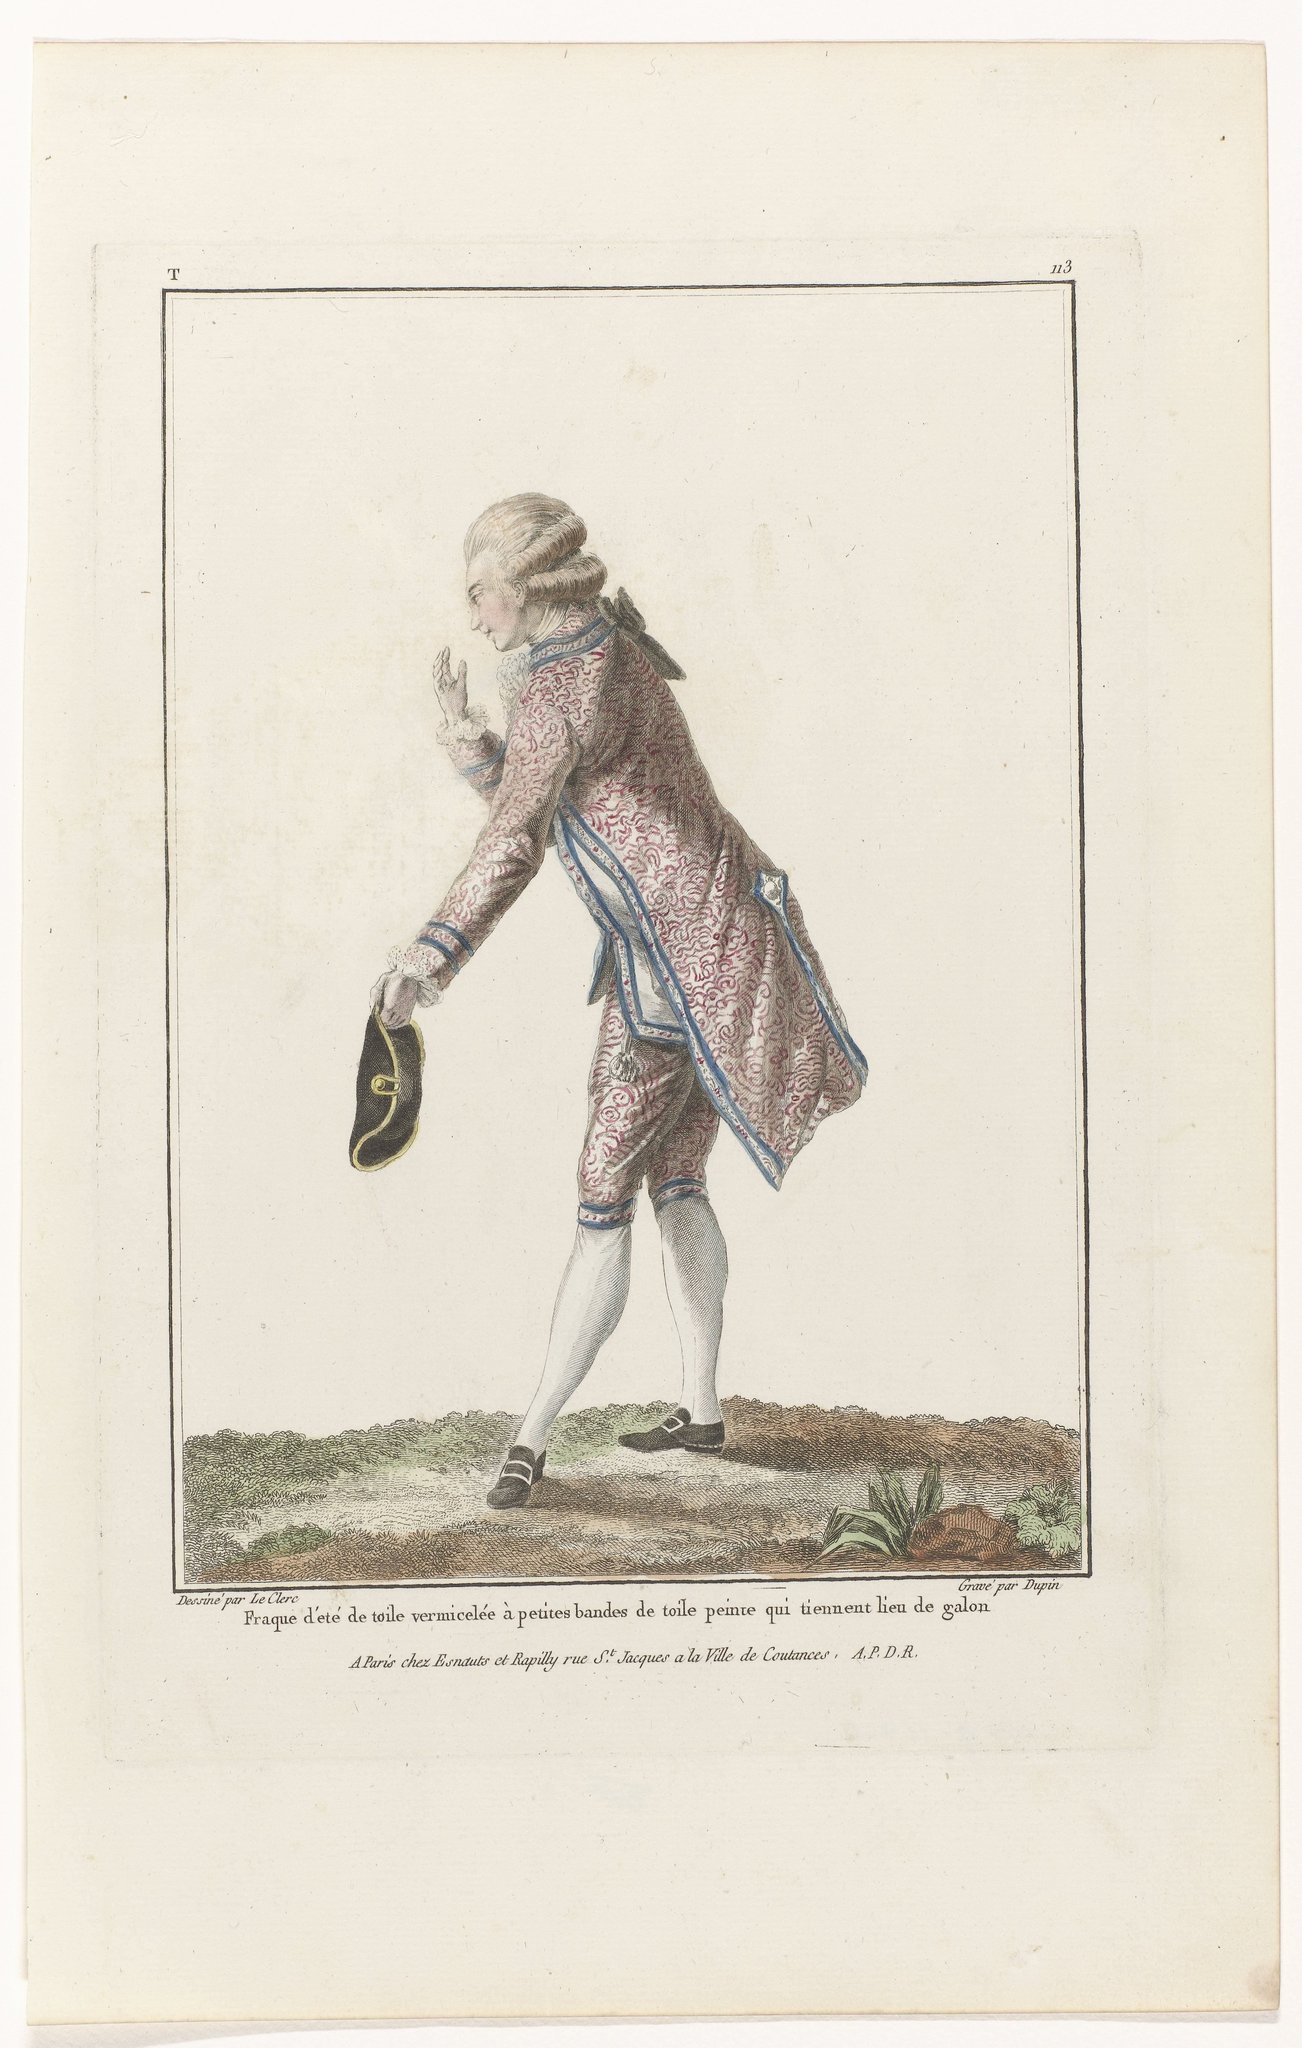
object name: fashion print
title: Gallerie des Modes et Costumes Français, 1776, T 113 : Fraque d'été de toil (...)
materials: paper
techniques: engraving, hand coloring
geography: paris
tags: head-gear: tricorn (+ men's clothes), clothing for the upper part of the body (vest) (+ men's clothes), coat (frac) (+ men's clothes), fashion plates, shoes, sandals (+ men's clothes), trousers, breeches, etc. (breeches) (+ men's clothes), stockings, socks (+ men's clothes)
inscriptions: address: ‘A Paris chez Esnauts et Rapilly, rue St. Jacques, a la Ville de Coutances. A.P.D.R.’, caption: ‘Fraque d'eté de toile vermicelée à petites bandes de toile peinte qui tiennent lieu de galon.’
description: Een revérence makende man in knielange zomerjas (frak). De jas heeft een krullenpatroon en is afgezet met smalle randen van beschilderde stof in plaats van galon. Onder de jas een halsdoek, vest, jabot en manchetten, kniebroek en kousen. Staartpruik met haarzak. In de linkerhand een steek afgezet met goudgalon en een knoop en lis. Schoenen met gesp. Prent uit serie T. 19e Cahier de Costumes Français, 12e Suite d'Habillemens à la mode depuis 1776, Gallerie des Modes et Costumes Français.